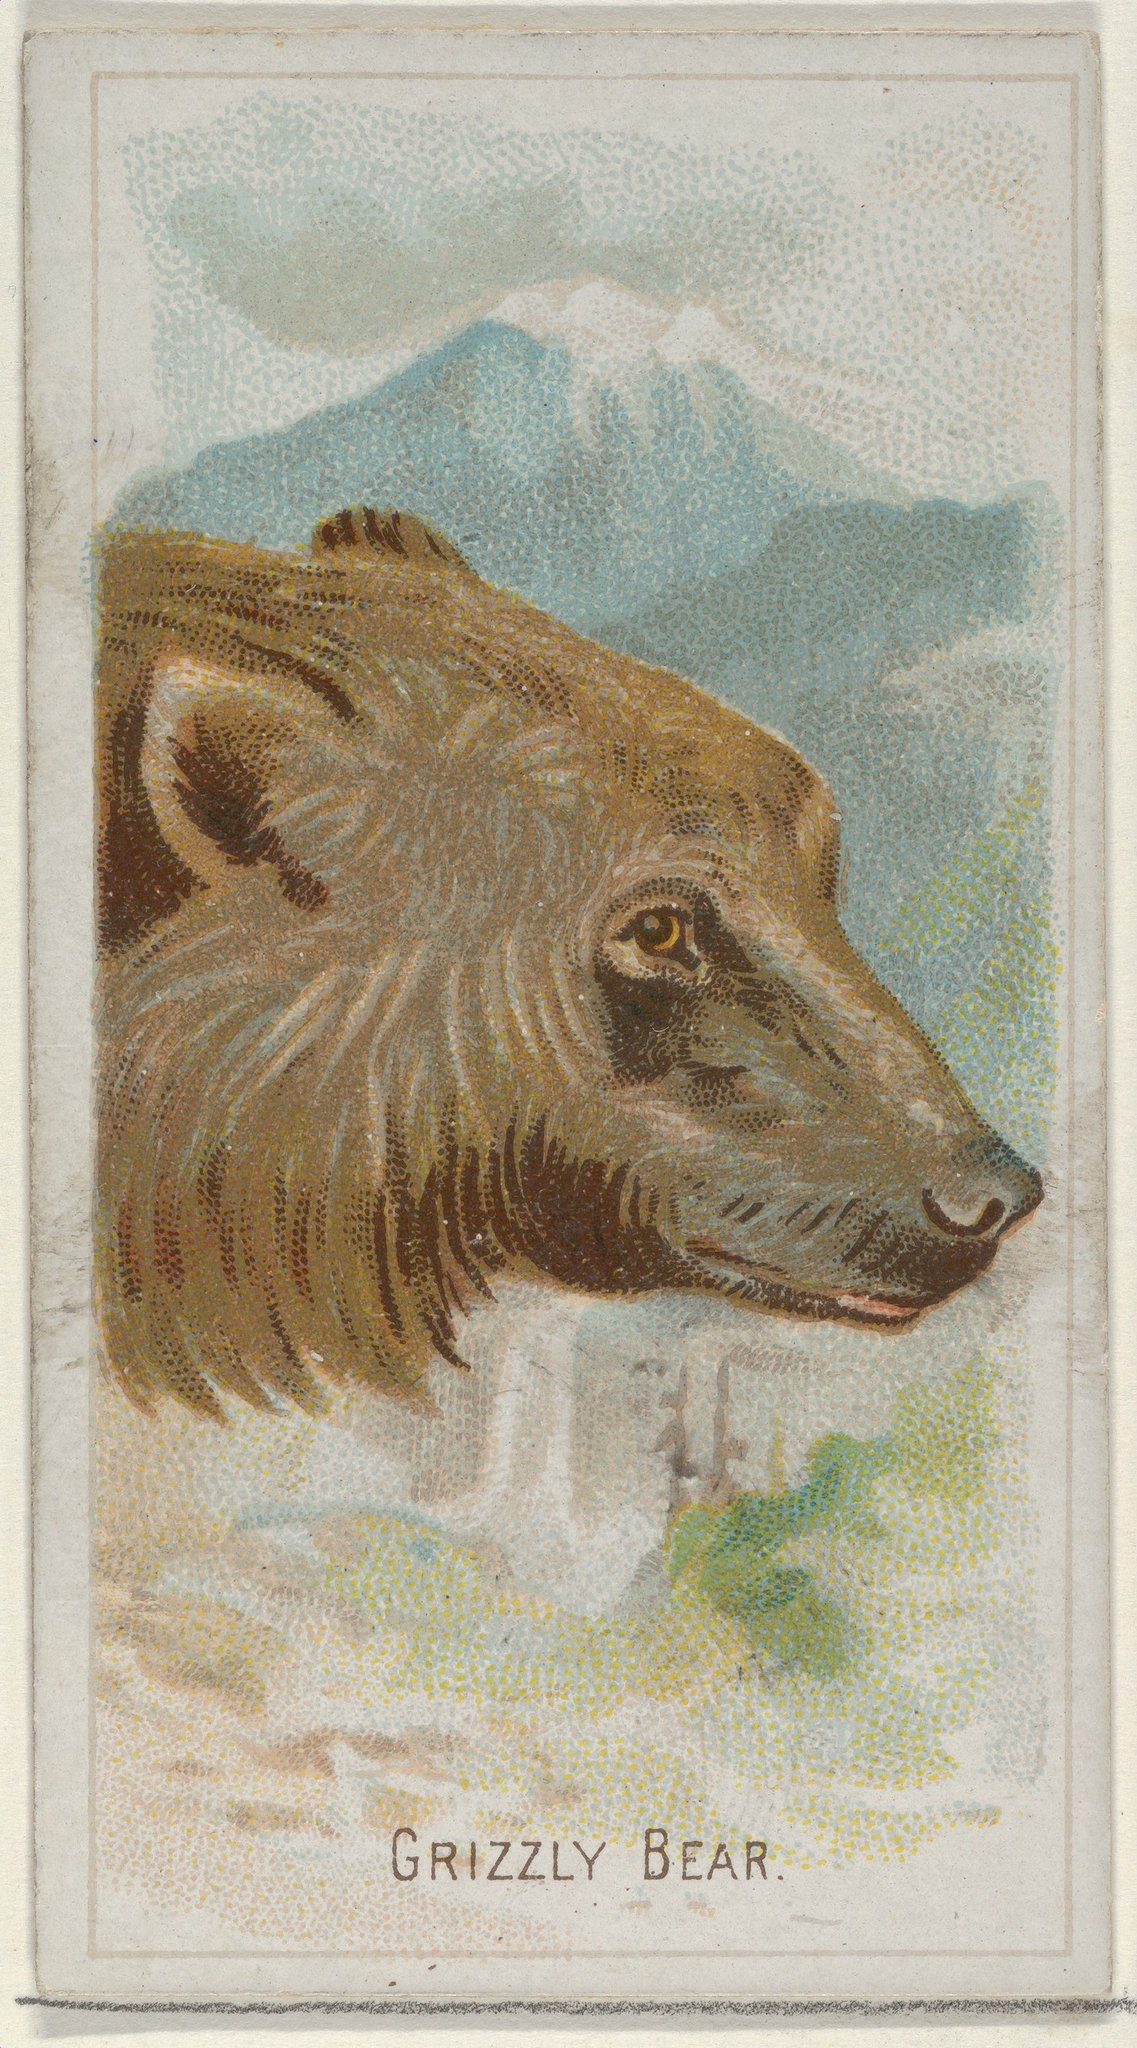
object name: print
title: Grizzly Bear, from the Wild Animals of the World series (N25) for Allen & Ginter Cigarettes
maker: allen & ginter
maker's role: publisher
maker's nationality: american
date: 1888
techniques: color lithograph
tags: bears